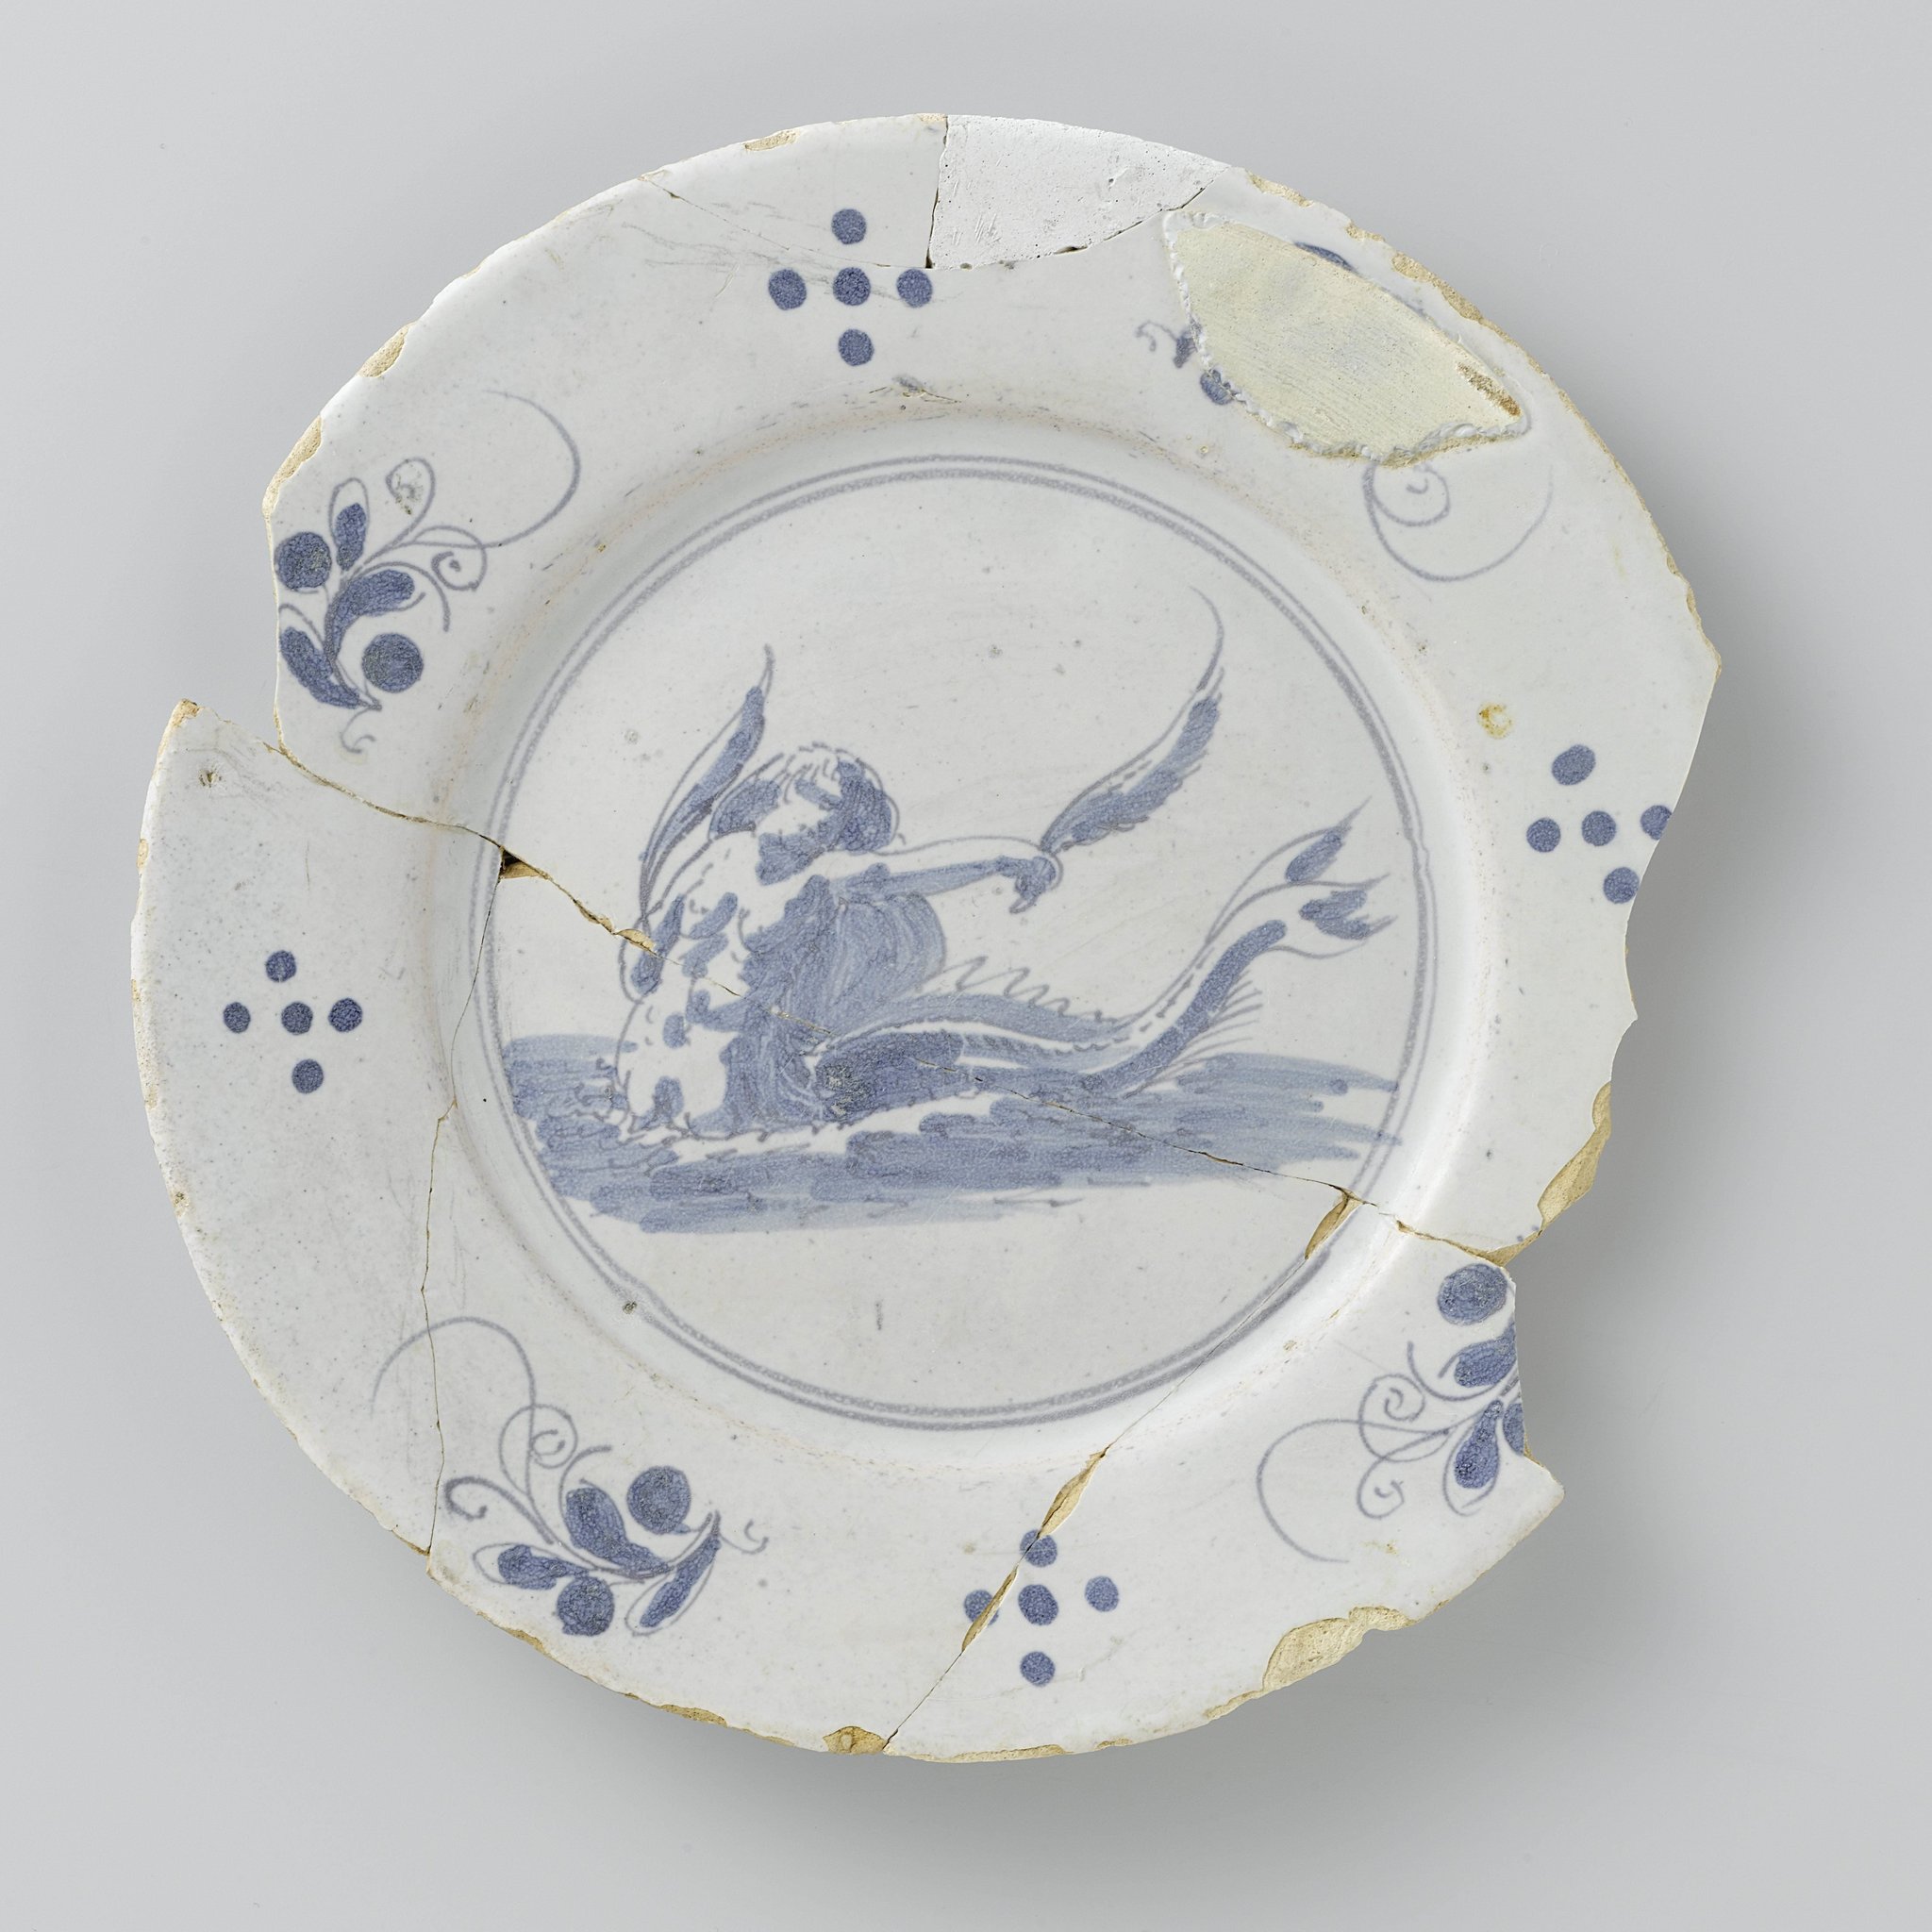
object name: plate dish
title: Fragmentarisch bord in blauw beschilderd met een zeegod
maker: Anonymous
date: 1645-1660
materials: earthenware, glaze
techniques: painted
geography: delft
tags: delft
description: Bodemvonds. gerestaureerd (inventariskaart). Volgens mondelinge mededeling (26-04-2019) door Theo van Halderen gevonden in een beerput op de Gasthuislaan in Delft.